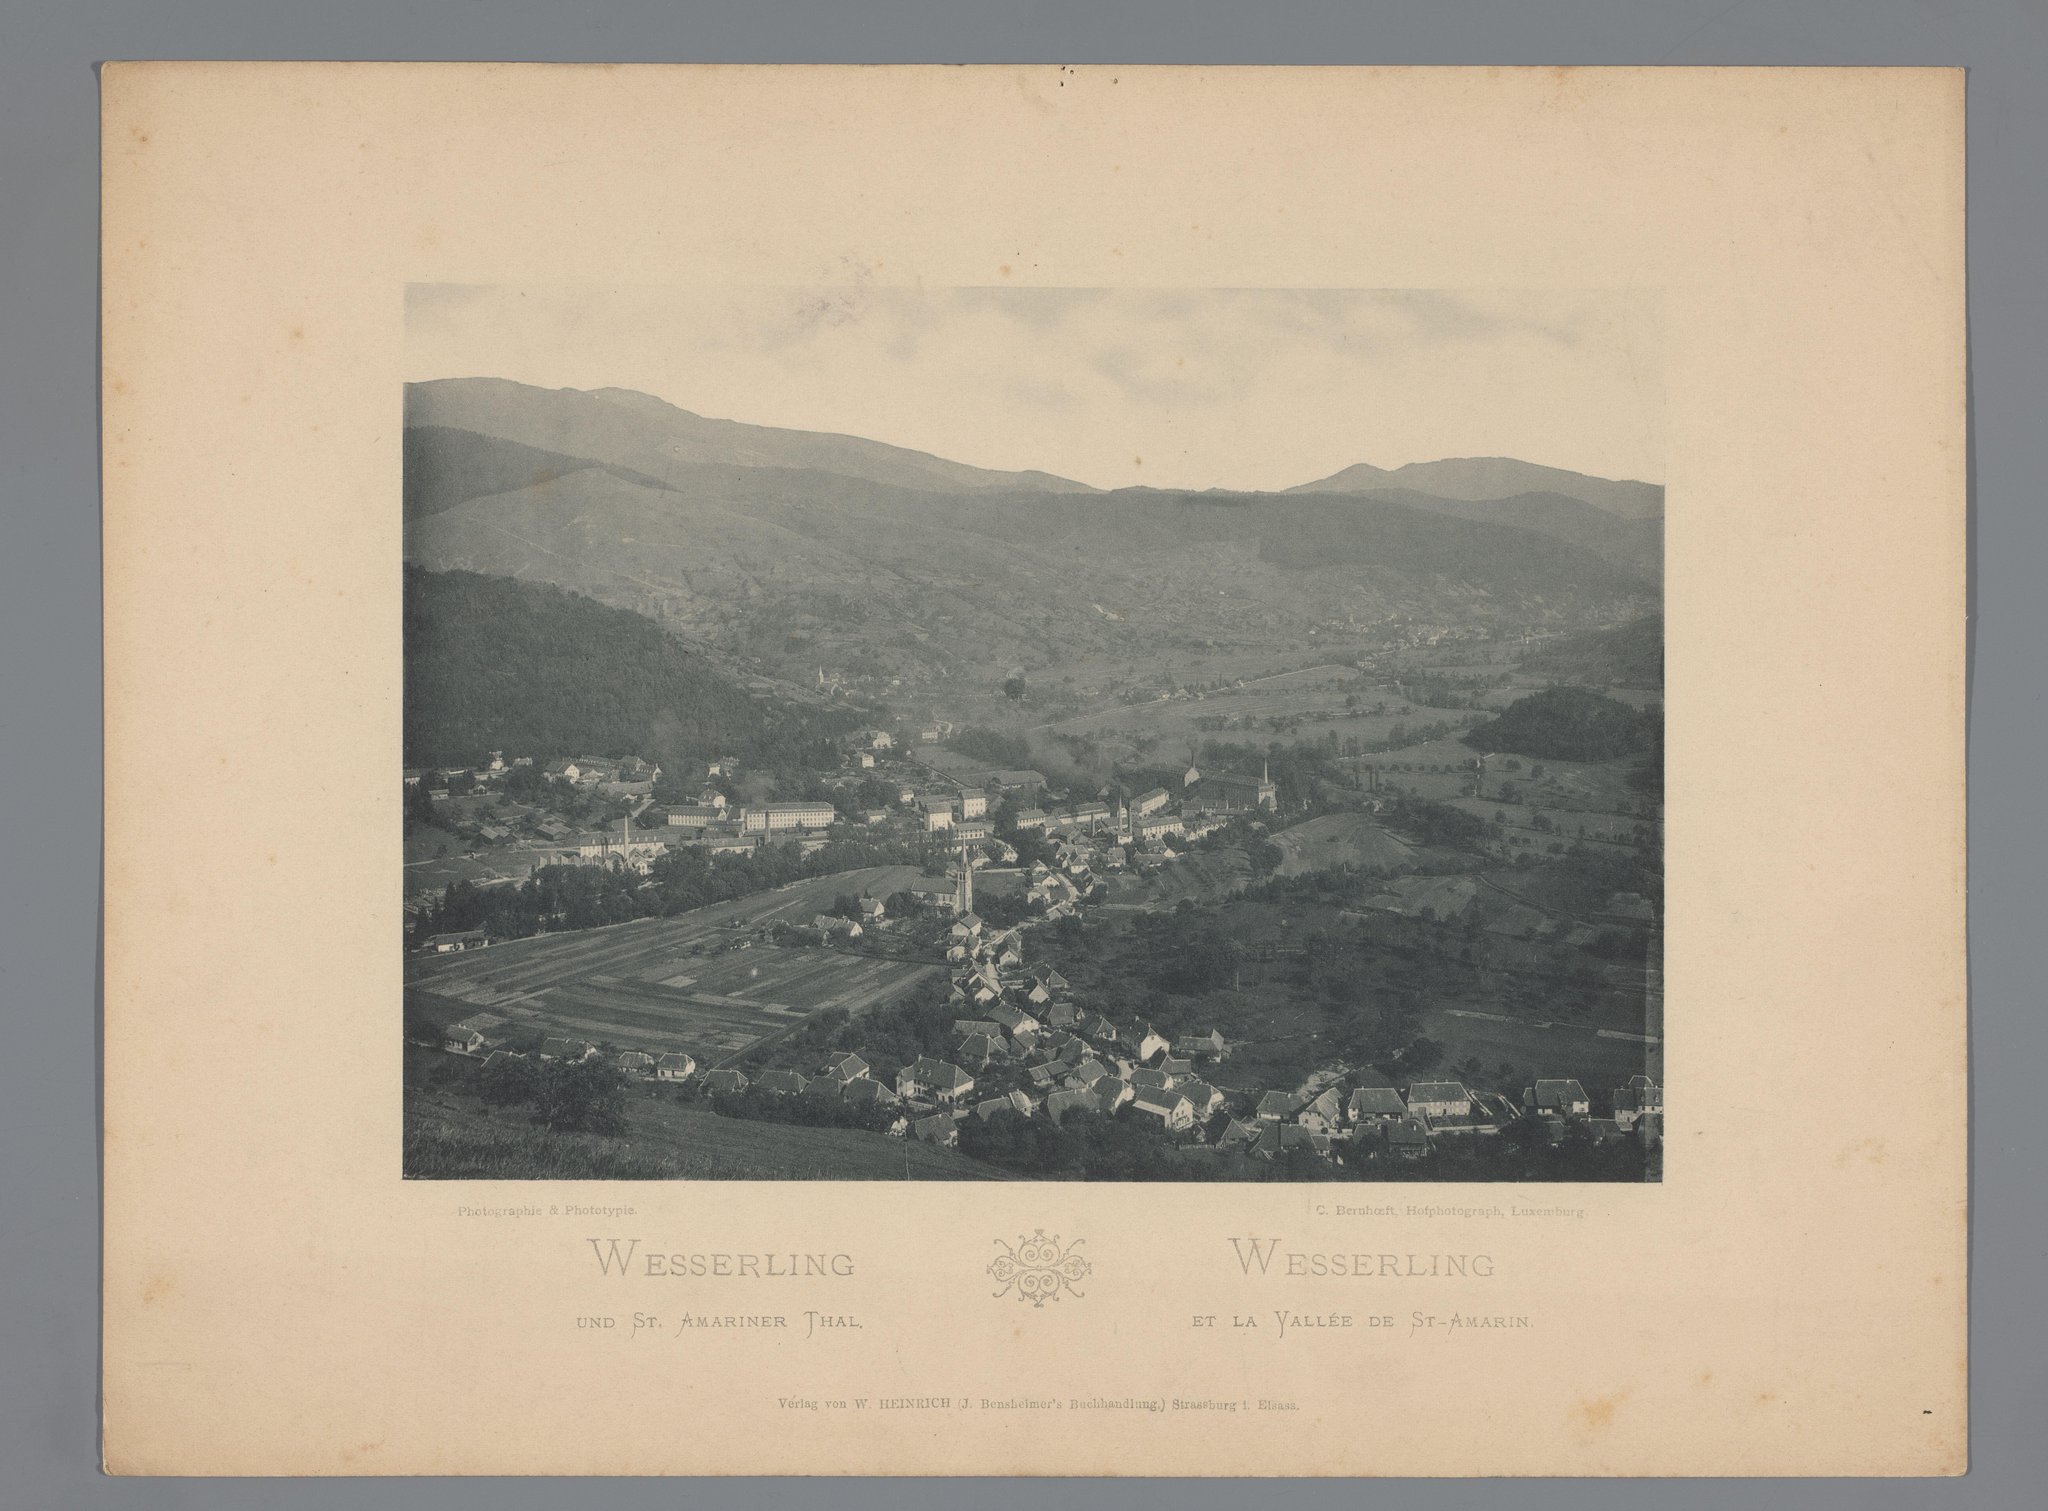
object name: photomechanical print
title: Wesserling, Wesserling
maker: charles bernhoeft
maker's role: publisher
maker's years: 1859-1933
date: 1889-1894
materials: paper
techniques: photograph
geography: husseren-wesserling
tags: dale, valley, landscapes in the temperate zone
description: Deze prent maakt deel uit van een omslag met 100 prenten.